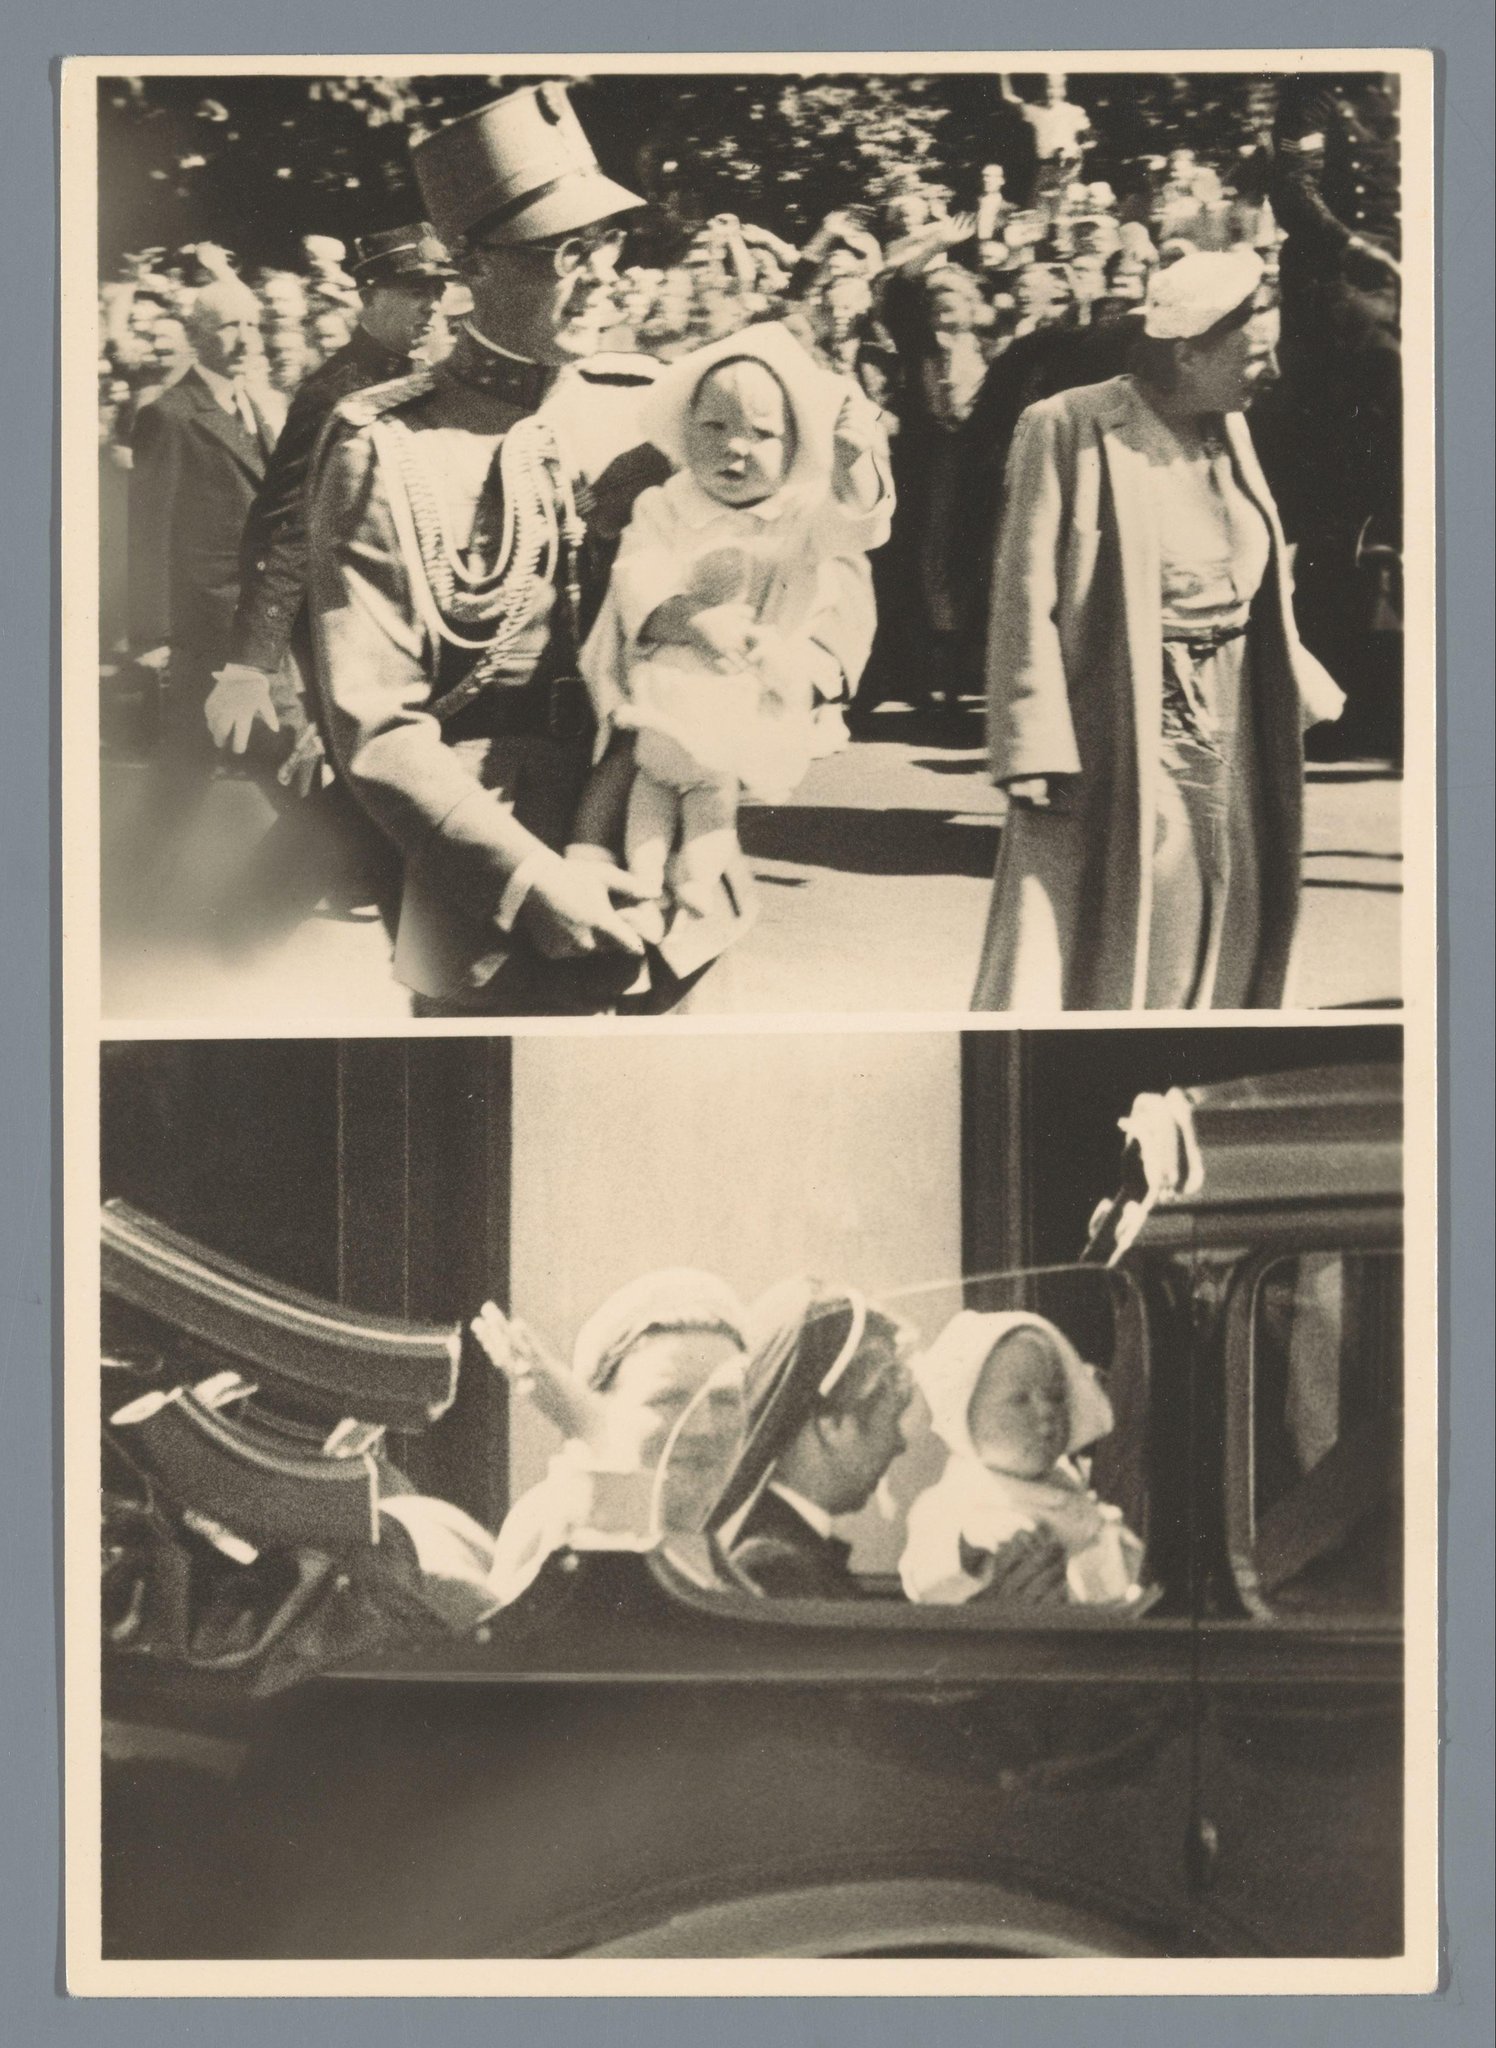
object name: photograph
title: Prins Bernhard draagt Beatrix op de arm en de koninklijke familie in een auto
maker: Anonymous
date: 1939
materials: photographic support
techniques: gelatin silver print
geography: the hague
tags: bernhard (prins der nederlanden), beatrix (koningin der nederlanden), the hague, juliana of the netherlands, crown princess, prince, princess